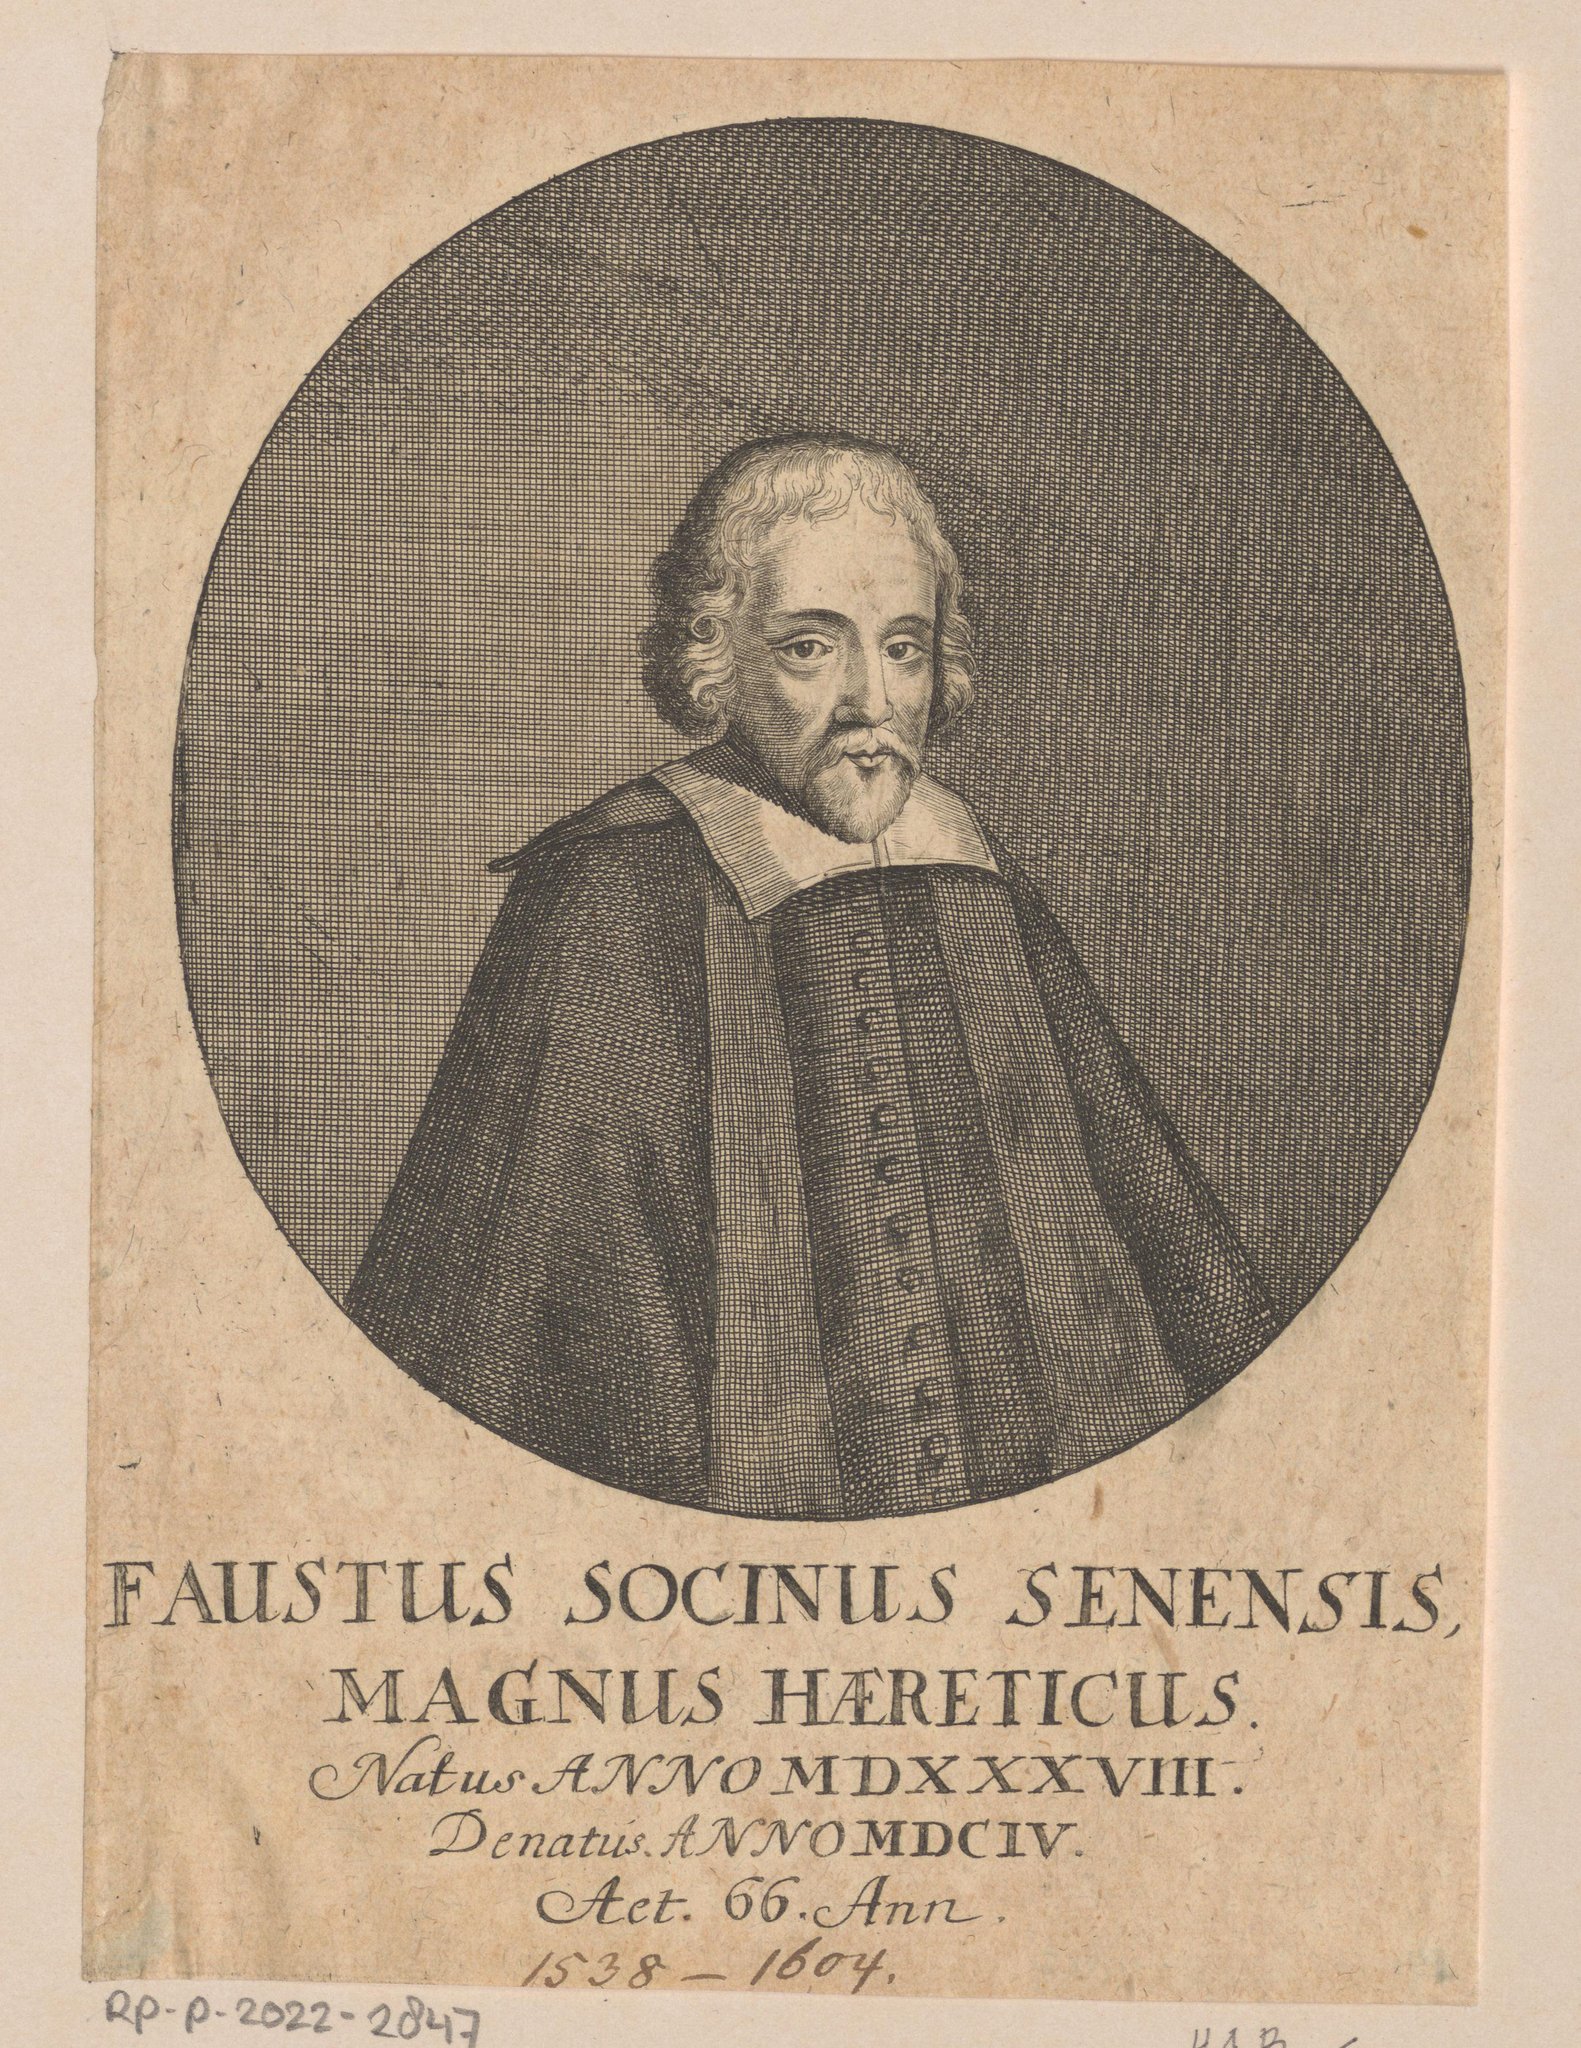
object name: print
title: Portret van Faustus Socinus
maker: Anonymous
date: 1702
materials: paper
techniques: engraving, etching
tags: theologian, historical persons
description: Prent waarschijnlijk uit: Corvinus, Johann Friedrich. Anabaptisticum Et Enthusiasticum Pantheon, Und Geistliches Rüst-Hauß (...). S.l.s.n., 1702.